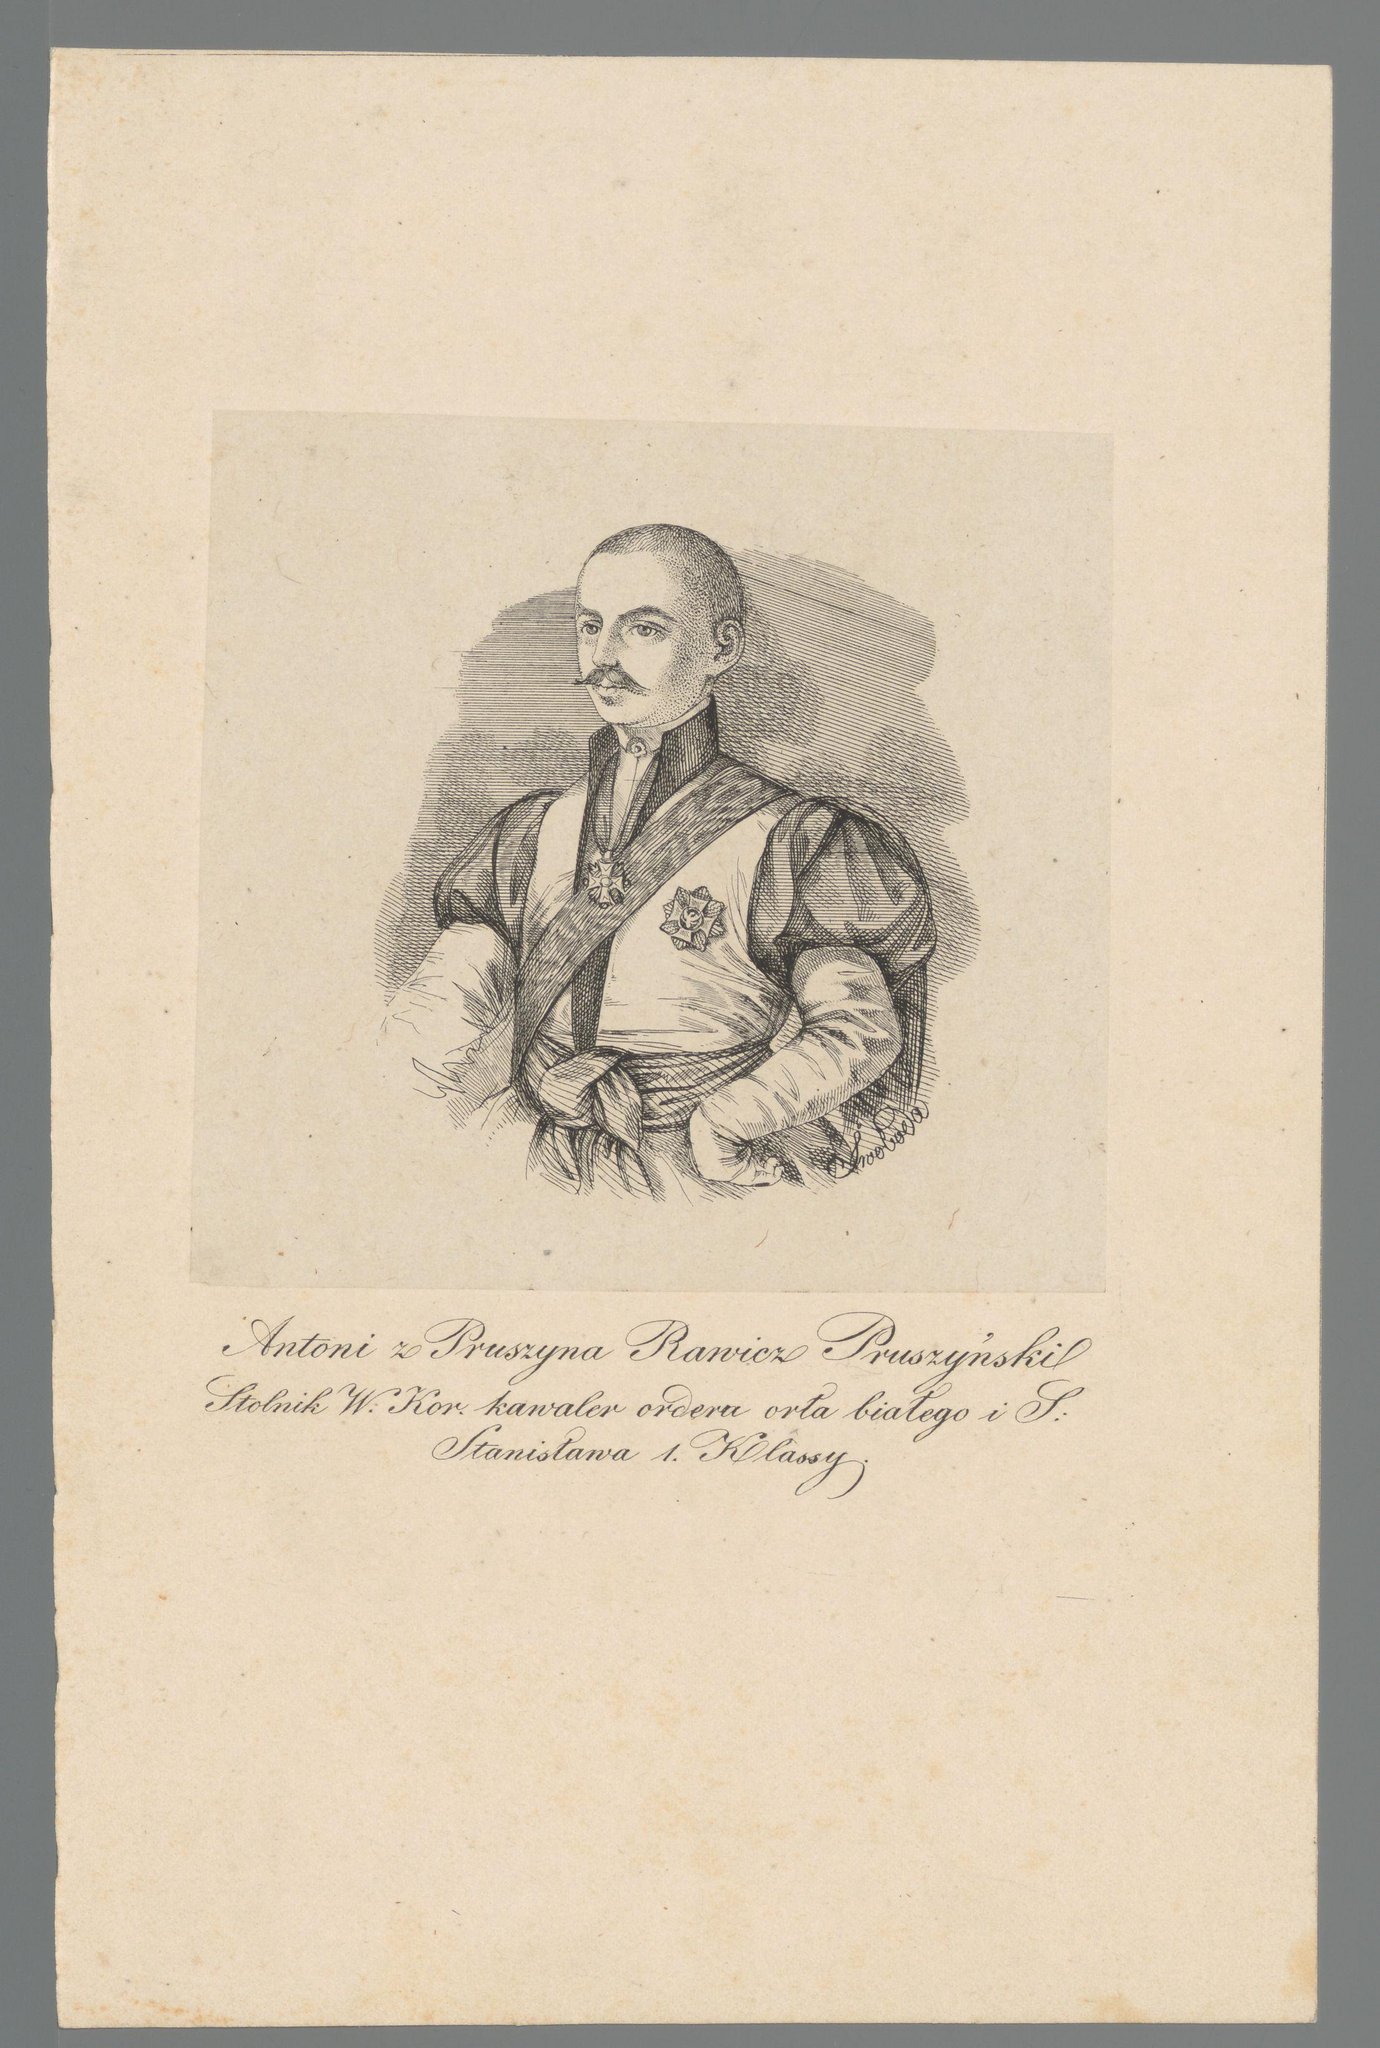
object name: print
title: Portret van Antoni Pruszyński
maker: eduard swoboda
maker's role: print maker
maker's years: 1814-1902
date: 1820-1890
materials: paper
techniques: lithograph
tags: moustache, adult man, historical persons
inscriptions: collector's mark: Lugt 2228